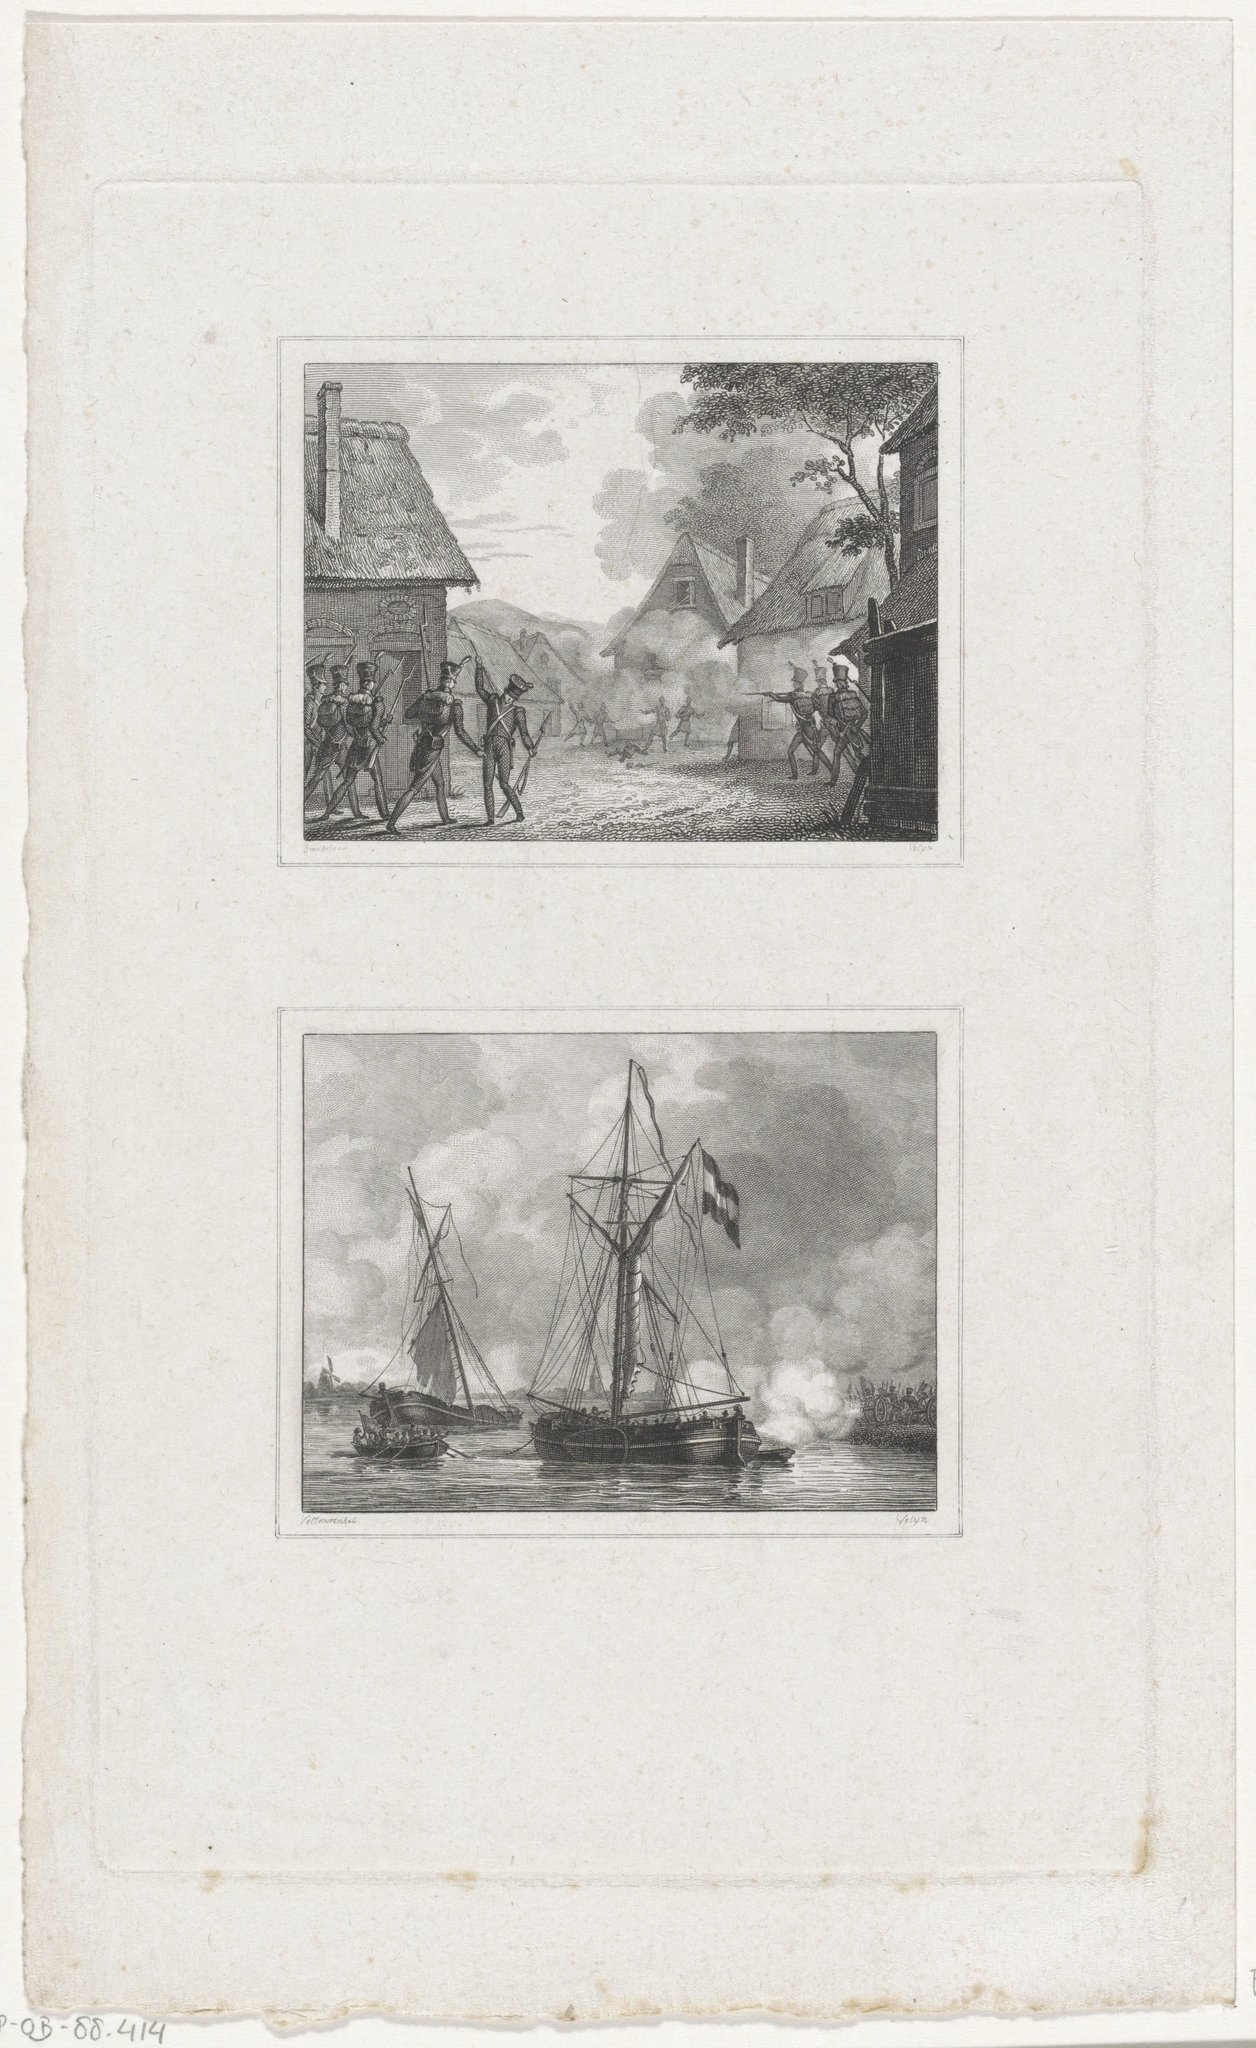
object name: history print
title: De student Huët te Oostham gedood / Gevecht bij het Hazegras; tijdens de Tiendaagse Veldtocht, 1831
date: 1831-1835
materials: paper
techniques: engraving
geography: netherlands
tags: small groups in single combat in place of battle, battle (+ naval force)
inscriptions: collector's mark: Lugt 2228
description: Blad met twee gebeurtenissen uit de Tiendaagse Veldtocht. Boven: de student Huët wordt bij schermutselingen te Oostham gedood. Onder: Gevecht bij het Hazegras (5 augustus). Onderdeel van een groep van 24 illustraties uit het boek van Olivier over de Tiendaagse Veldtocht, 2-12 augustus 1831.